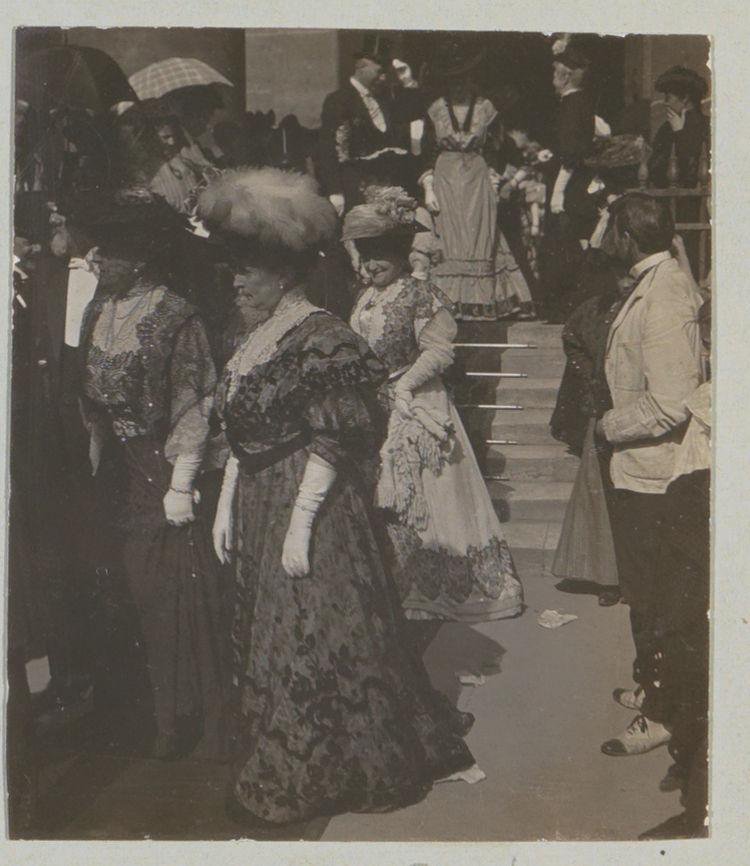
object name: photograph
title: Bruiloftsgasten bij het verlaten van een gebouw, vermoedelijk in Italië of Frankrijk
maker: Anonymous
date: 1905-1910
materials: paper, photographic support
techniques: gelatin silver print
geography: europe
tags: members of bridal party, dress, gown, europe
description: Onderdeel van Fotoalbum van een Franse amateurfotograaf met bezienswaardigheden in Frankrijk, Zwitserland en Italië.